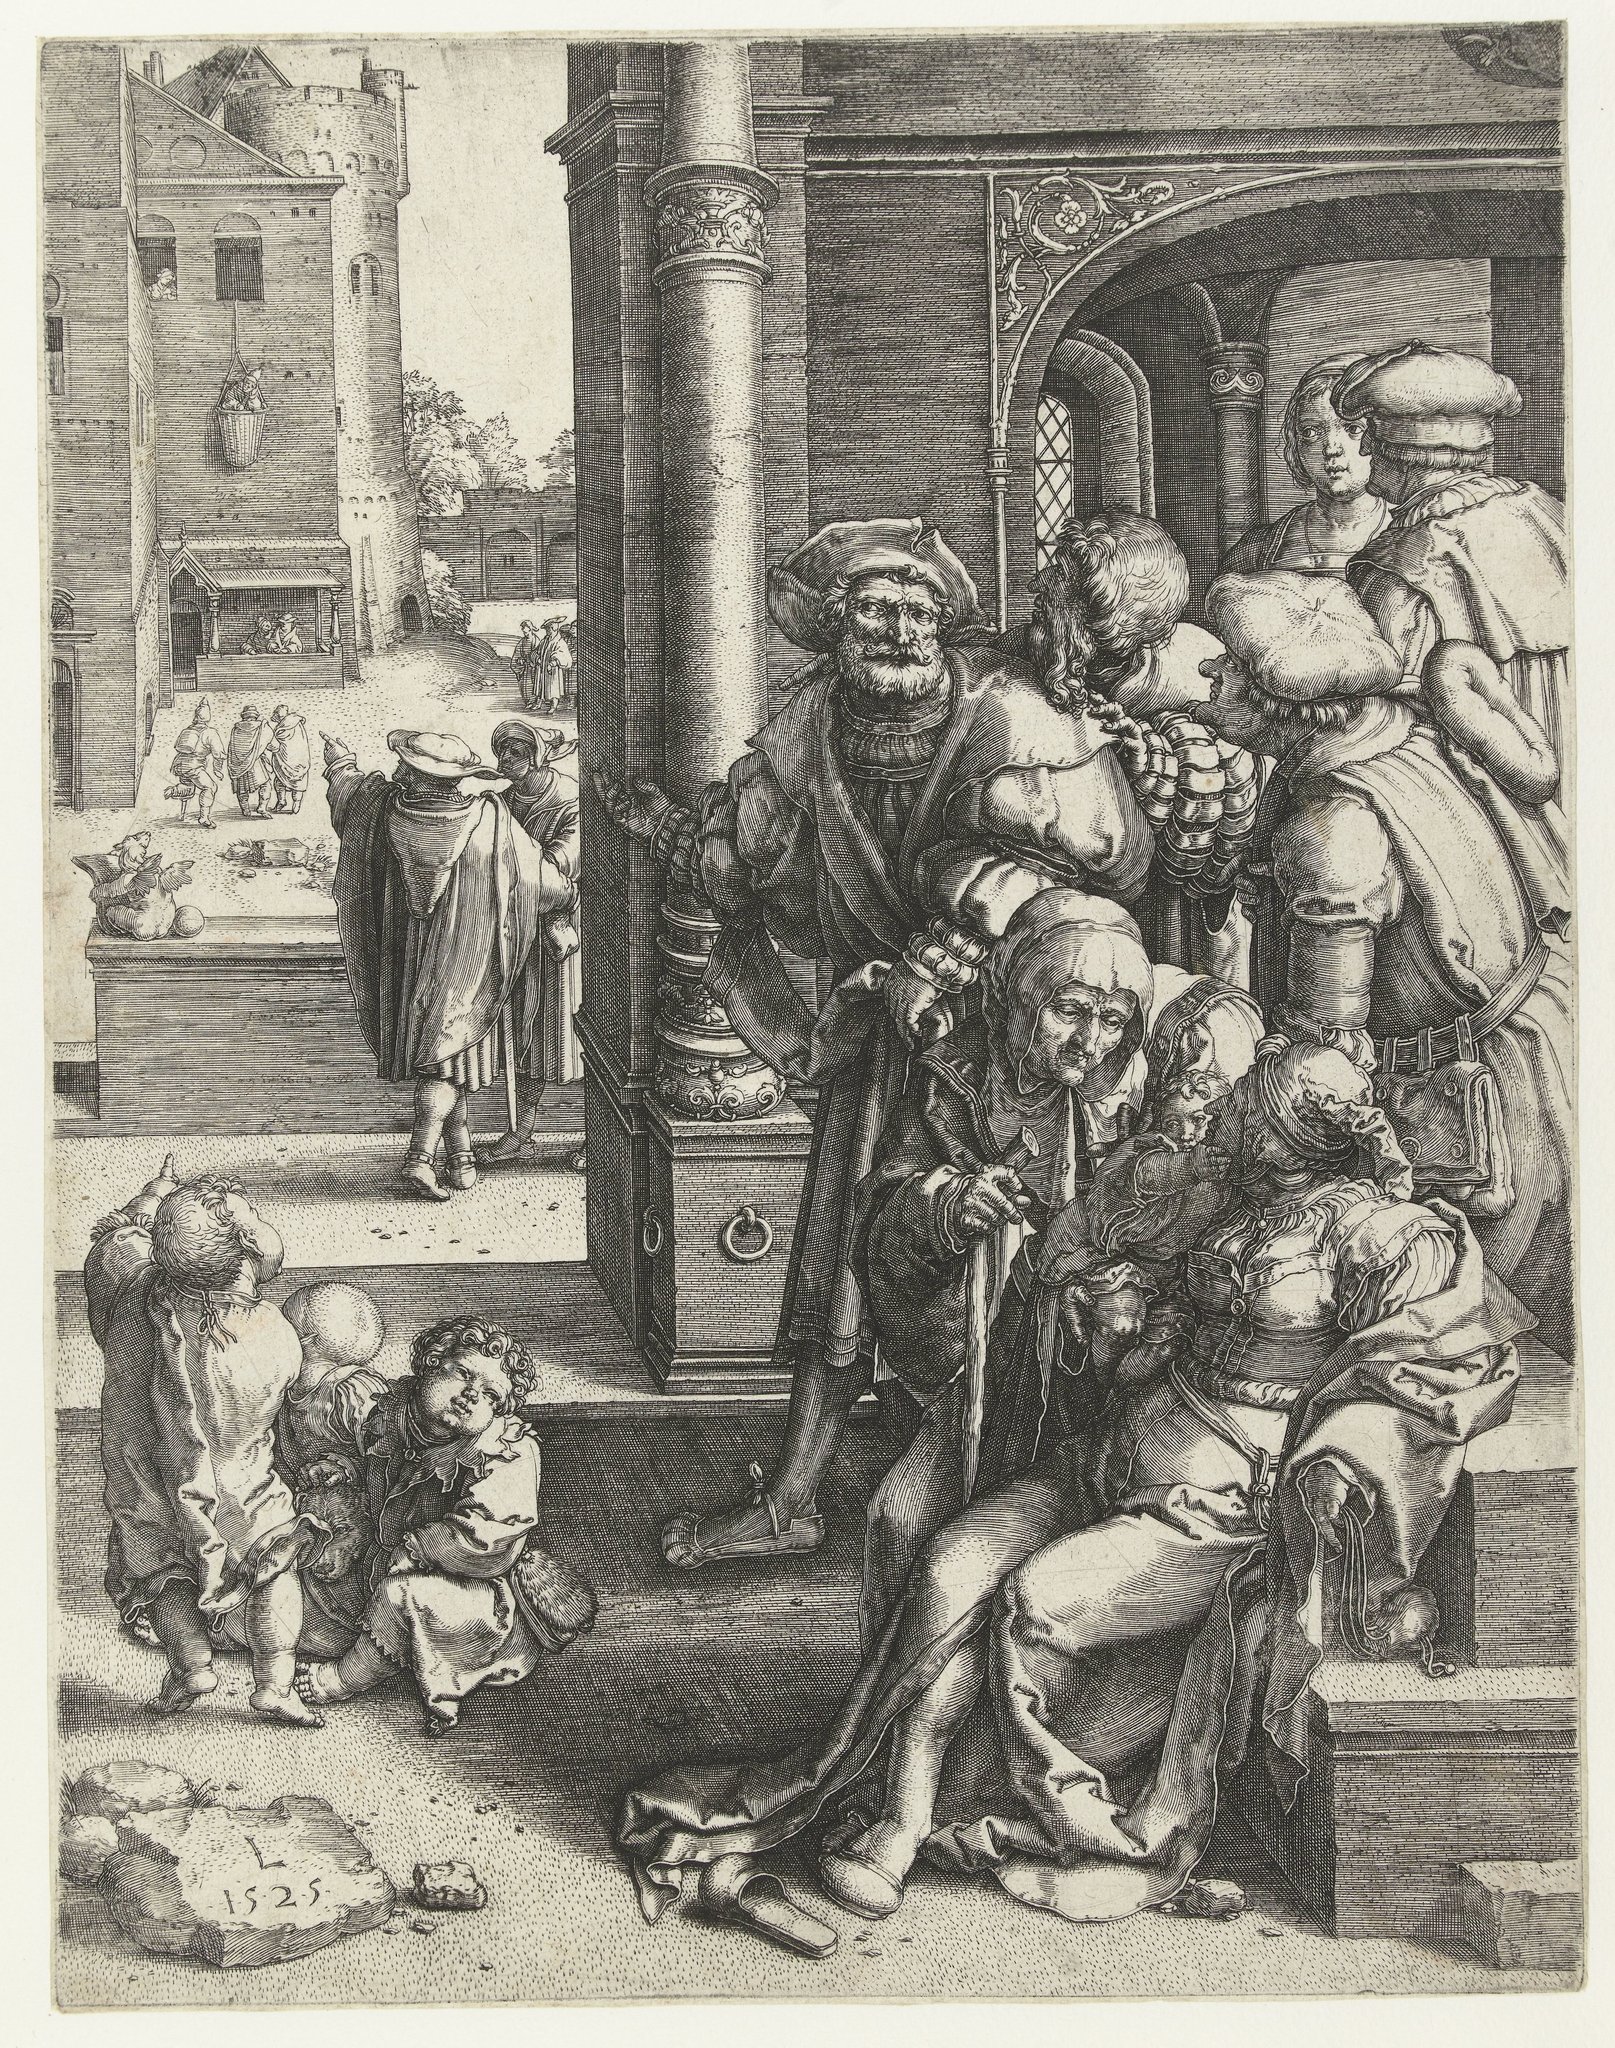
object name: print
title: The Poet Virgil in a Basket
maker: lucas van leyden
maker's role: draughtsman, painter, print maker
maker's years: 1494-1533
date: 1525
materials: paper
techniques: engraving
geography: low countries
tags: publius vergilius maro, head-gear: hat (+ men's clothes), virgil in the basket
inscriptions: inscription: ‘costugh(?) 4’, signature and date: ‘L 1525’, collector's mark: Lugt 240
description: The sorcerer Virgil fell madly in love with the daughter of a Roman emperor. The girl pretended to return his feelings: she would raise him to her bedroom in a basket at night. Instead, she lifted him halfway up the tower wall, and left him hanging there. Thanks to the glances of the scoffing onlookers in the foreground we can discern the dangling Virgil in the distance.